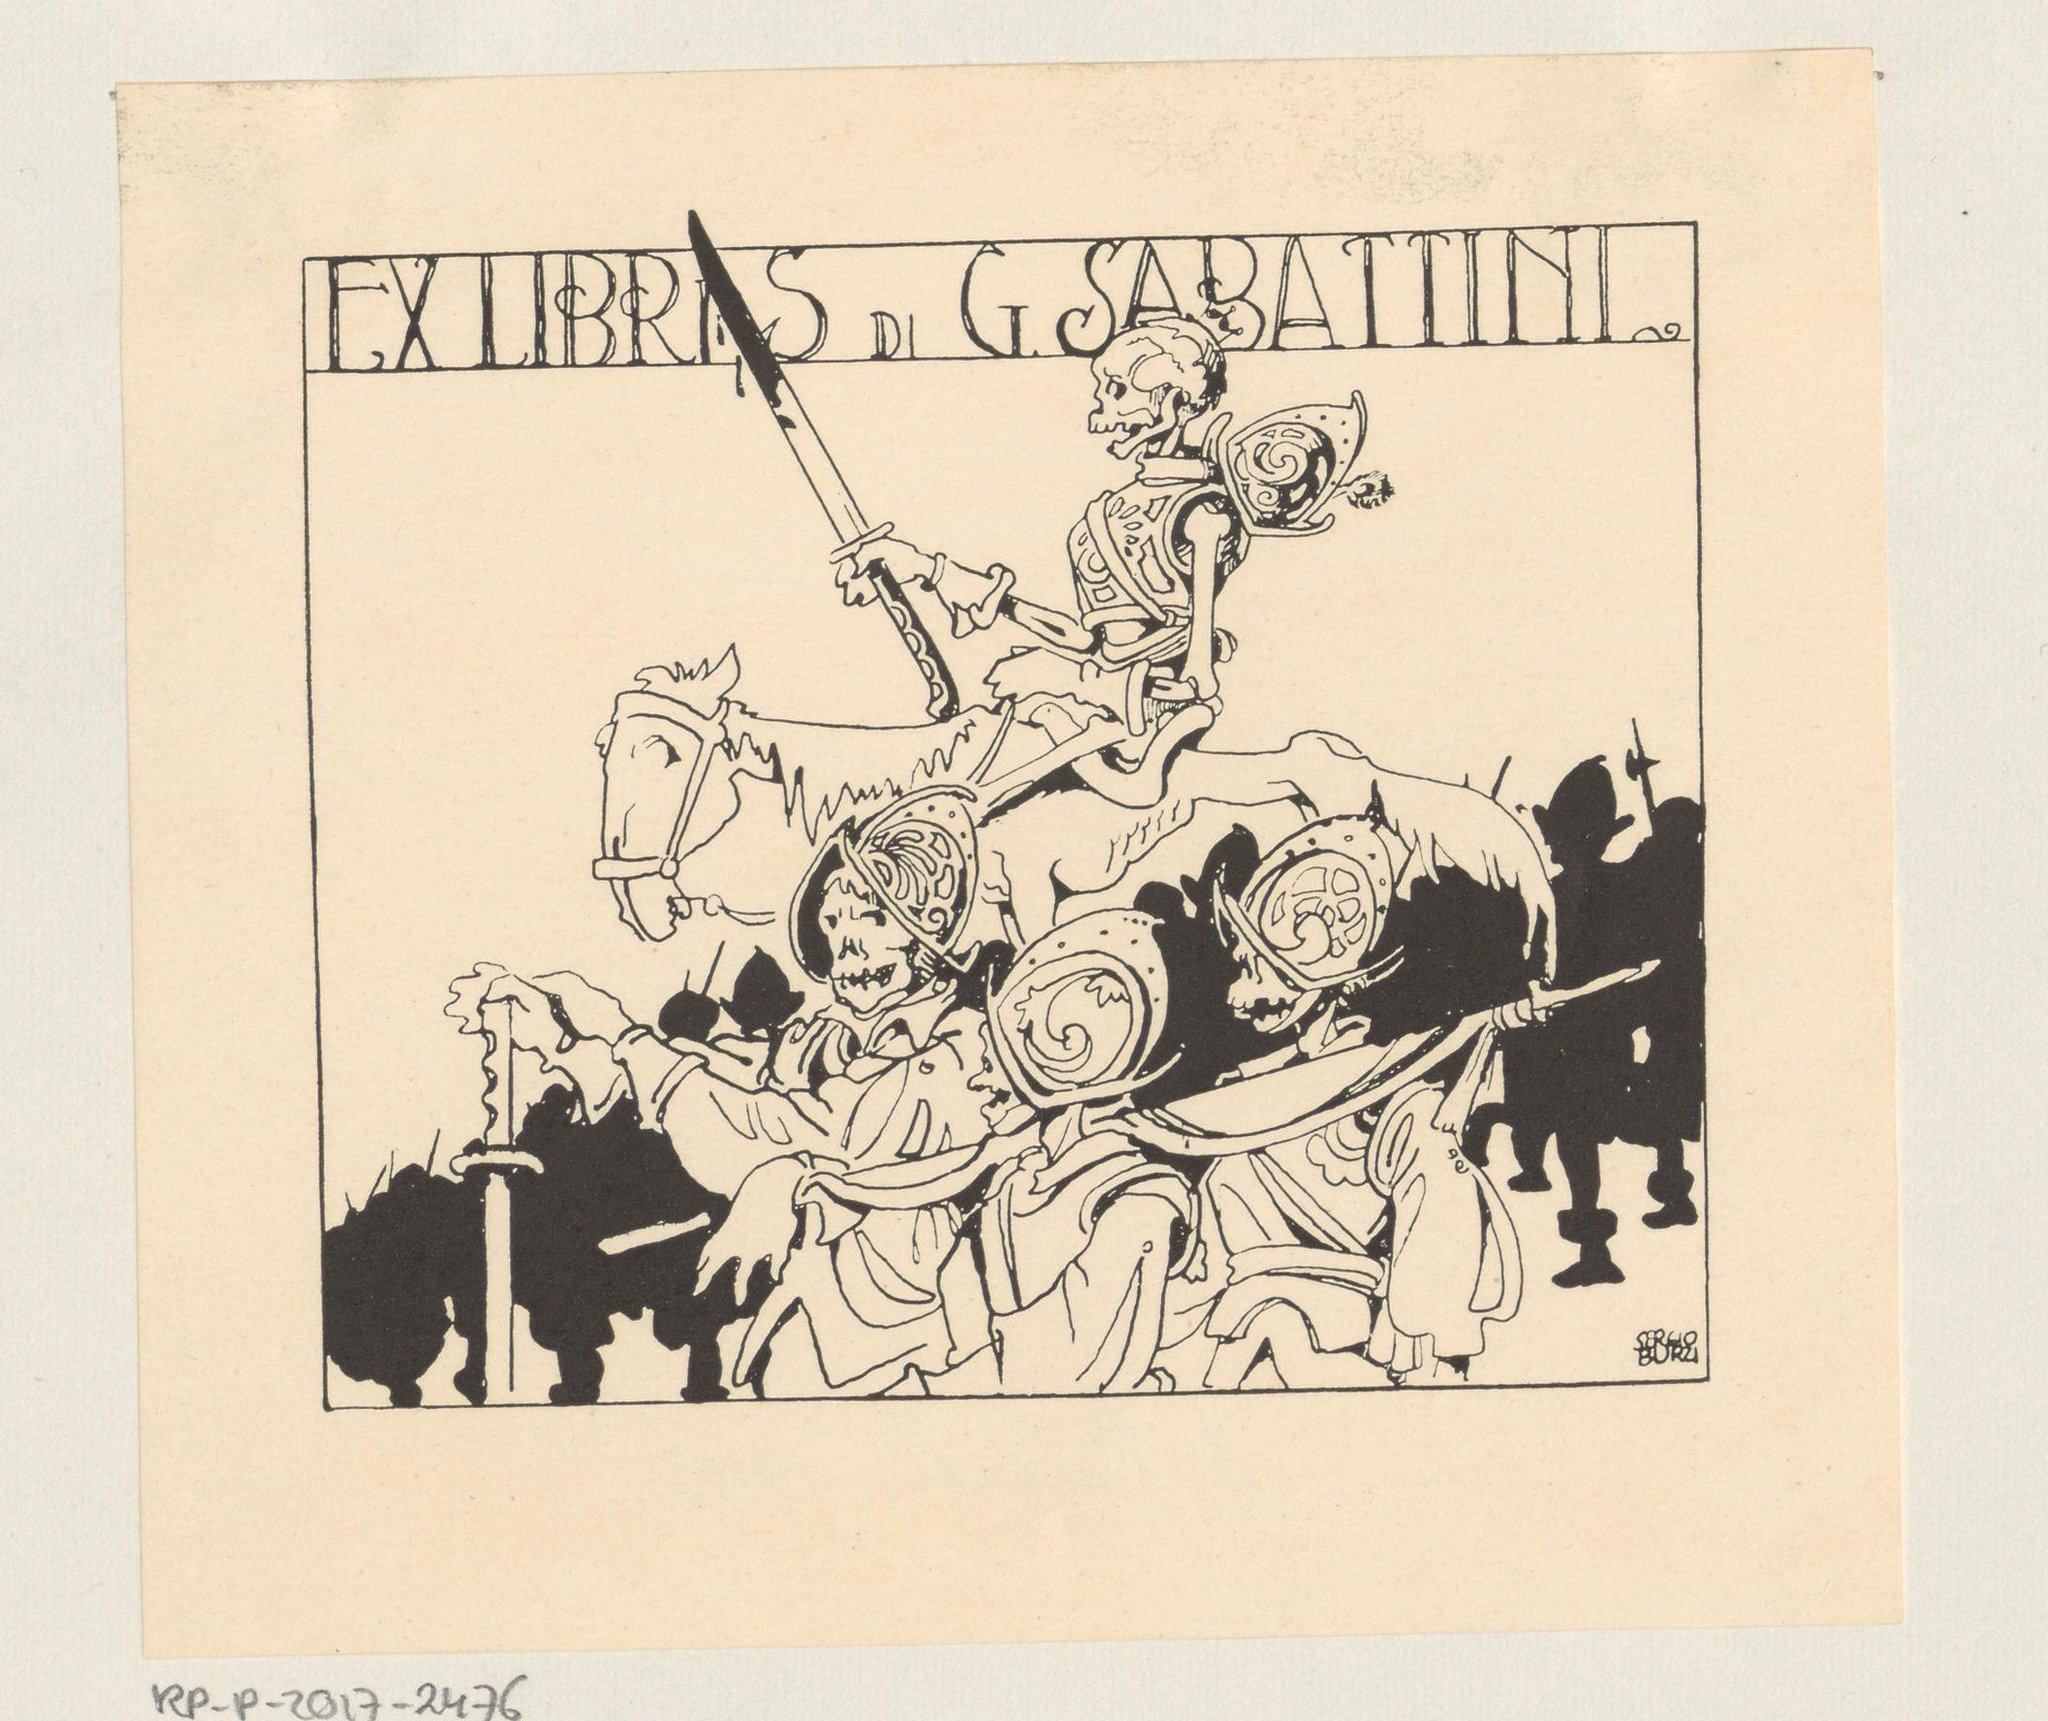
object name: bookplate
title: Ex libris van G. Sabattini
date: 1943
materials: paper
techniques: printing block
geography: italy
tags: gino sabattini, riding a horse, ass, or mule; rider, horseman, private soldier, death as skeleton, warfare; military affairs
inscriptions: inscription: ‘S. Burzi 1943’